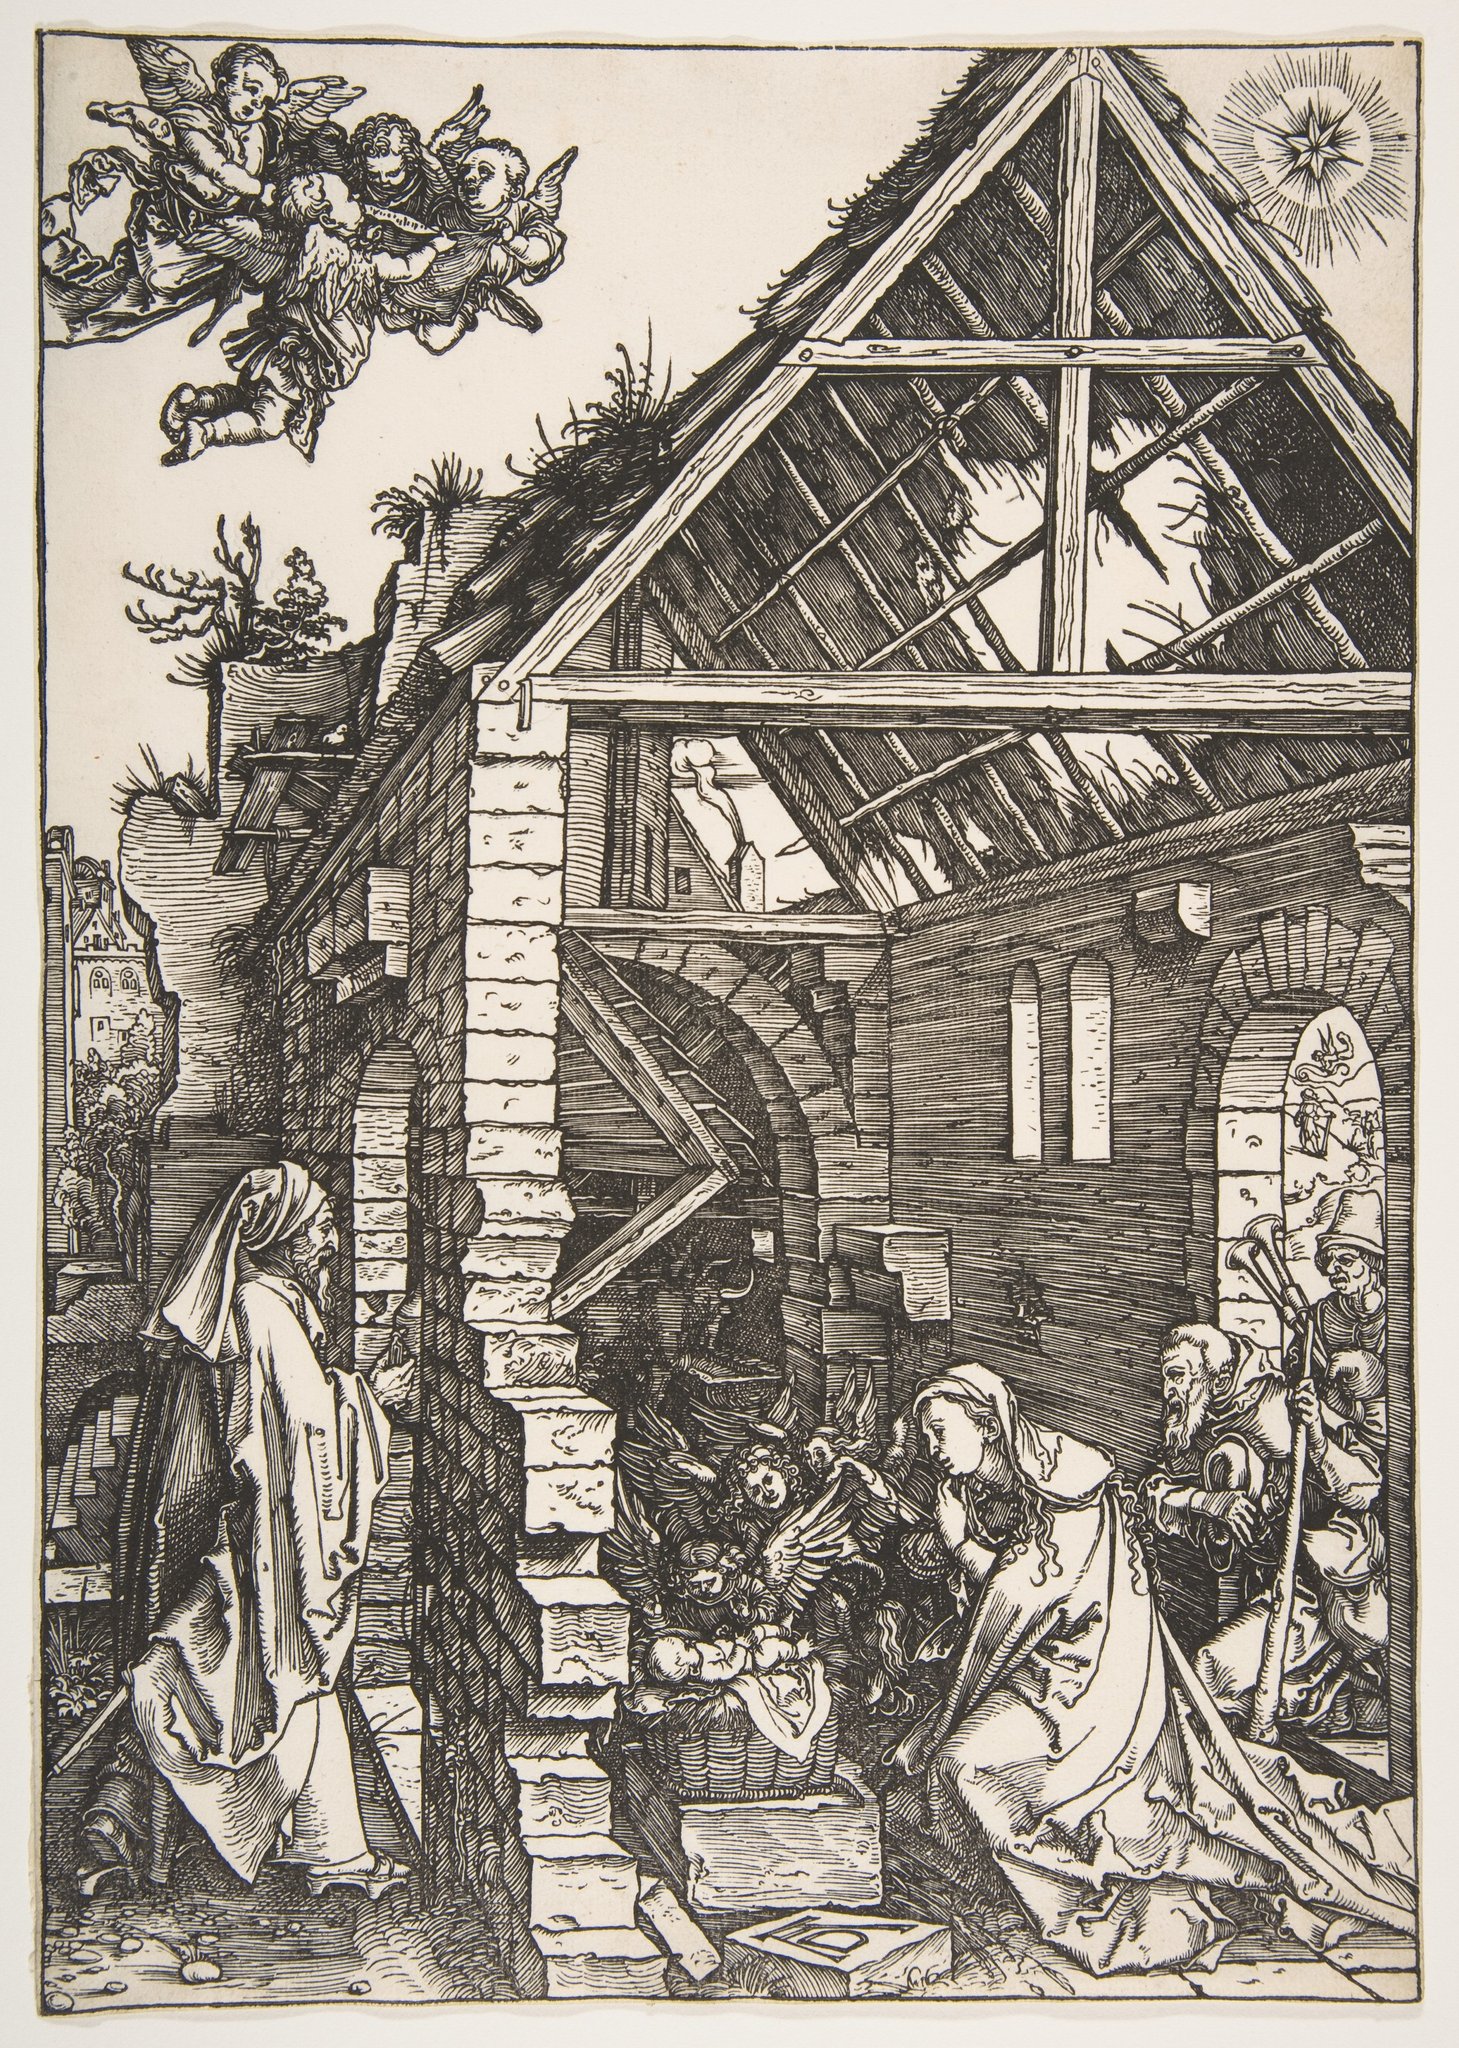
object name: print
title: The Nativity, from "The Life of the Virgin"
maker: albrecht dürer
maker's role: artist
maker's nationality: german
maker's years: 1471-1528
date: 1502-1503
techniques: woodcut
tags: men,angels,virgin mary,nativity